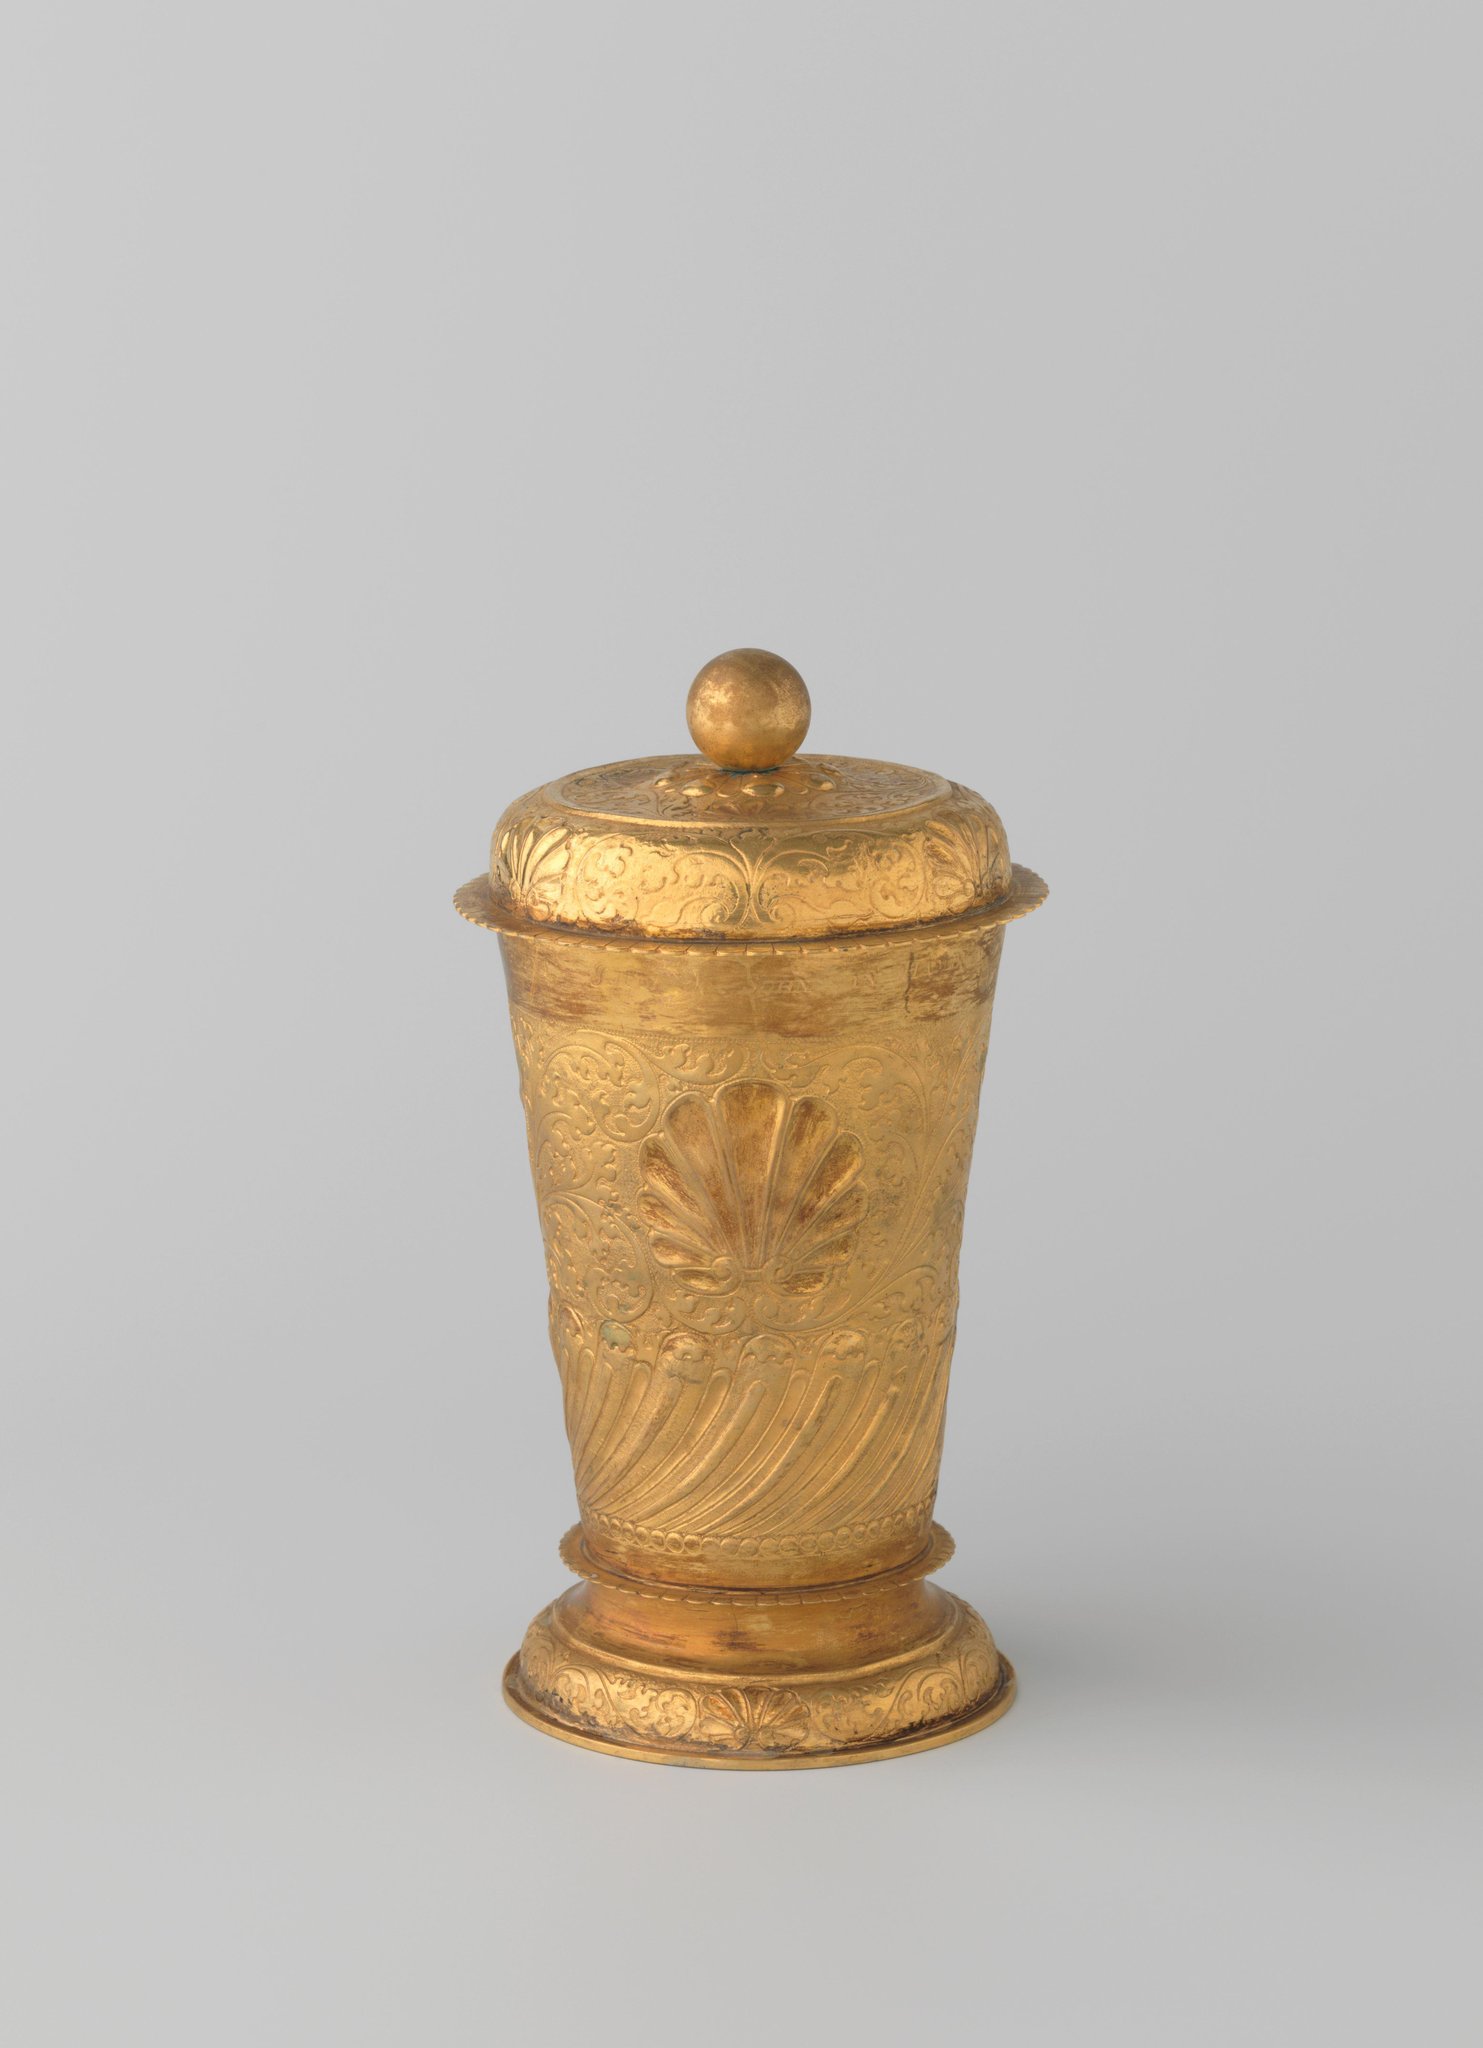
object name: kroes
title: Galvanoplastische reproductie van een beker met deksel, gedecoreerd met schelpen en bladvoluten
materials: copper, silver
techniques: gilding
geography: hamburg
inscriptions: inscription: ‘Jacob Marten, Hamburg, 4, 7ber 1708.’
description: Galvanoplastische reproductie van een beker met deksel, gedecoreerd met schelpen en bladvoluten. Met de inscriptie: Jacob Marten, Hamburg, 4, 7ber 1708.